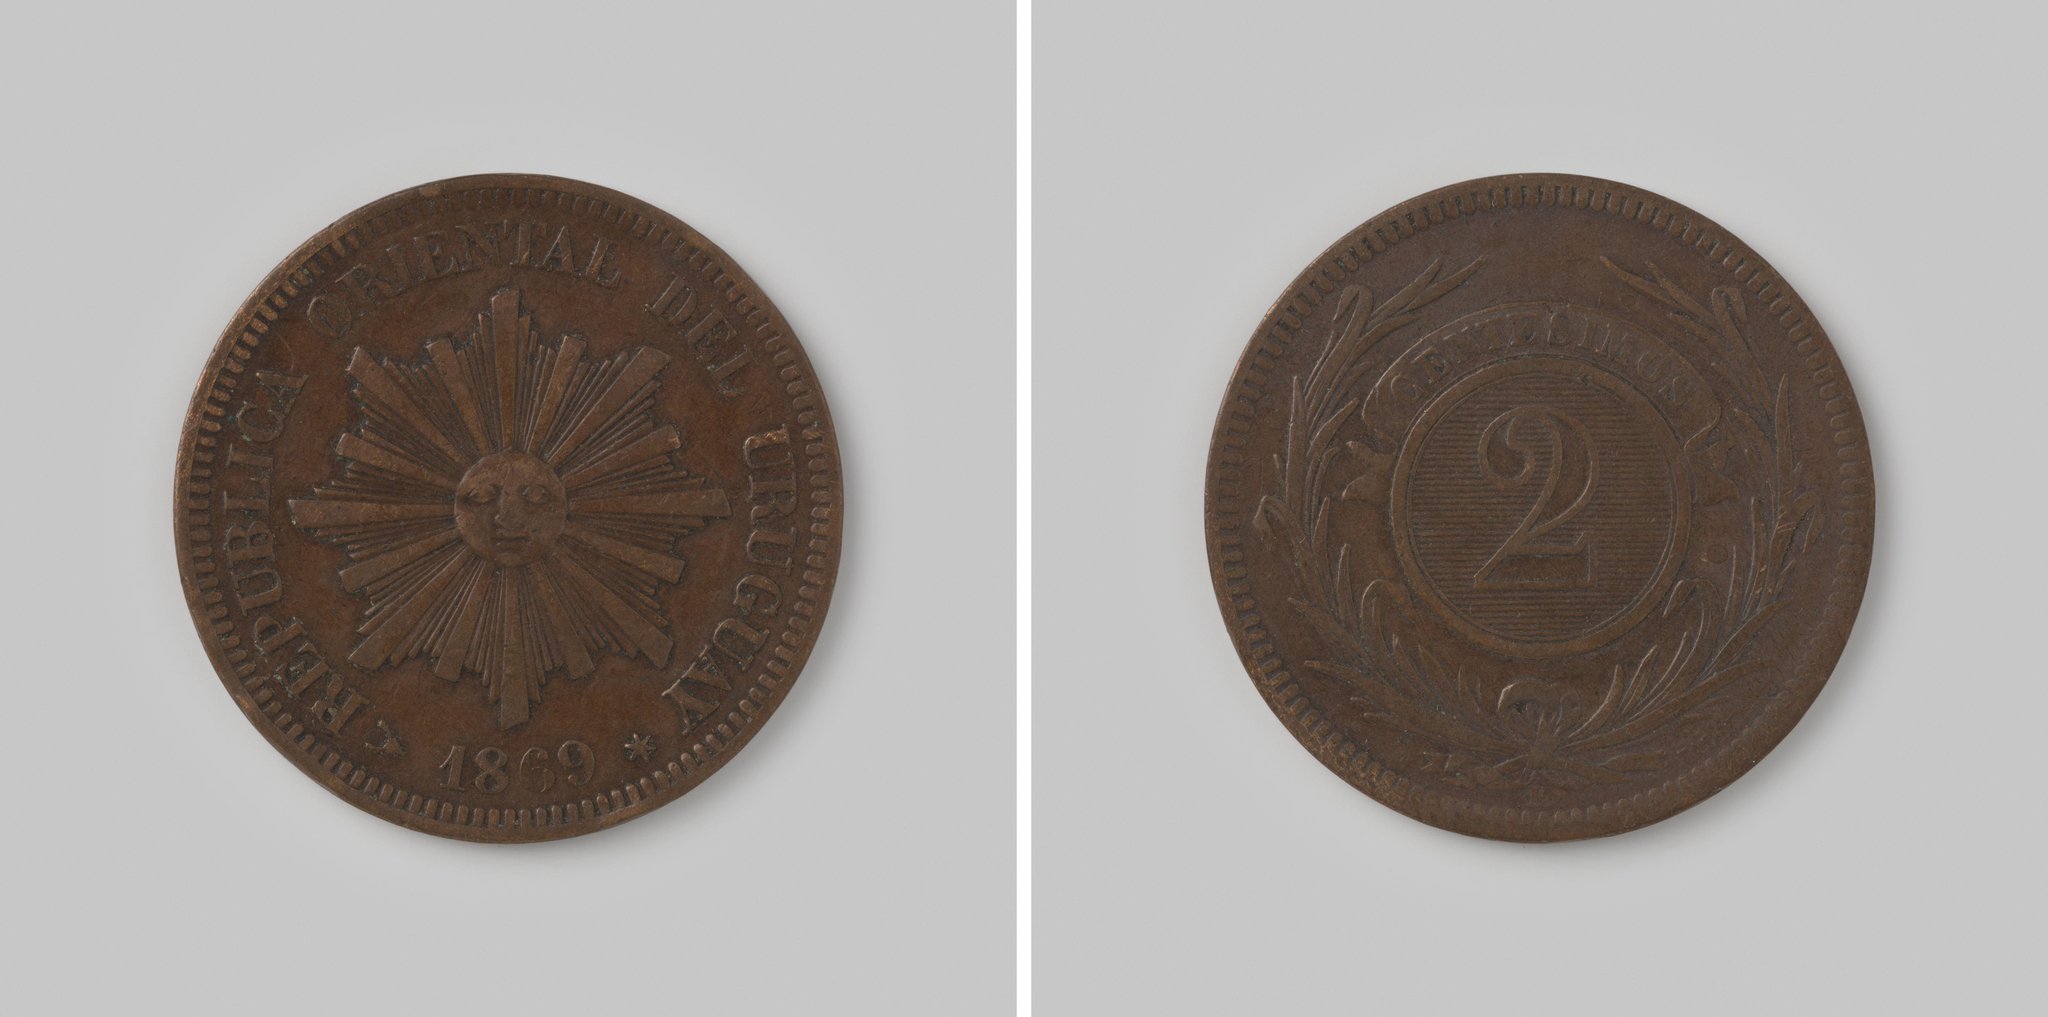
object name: coin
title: Uruguay, 2 centesimos, 1869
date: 1869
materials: copper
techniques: striking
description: Koperen munt. Voorzijde: door grote en kleine stralen omgeven zon, waarin mensengezicht. Jaartal onderaan. Keerzijde: tussen twee samengebonden takken in twee regels waarde-aanduiding: centesimos 2 in twee regels. Gladde rand.